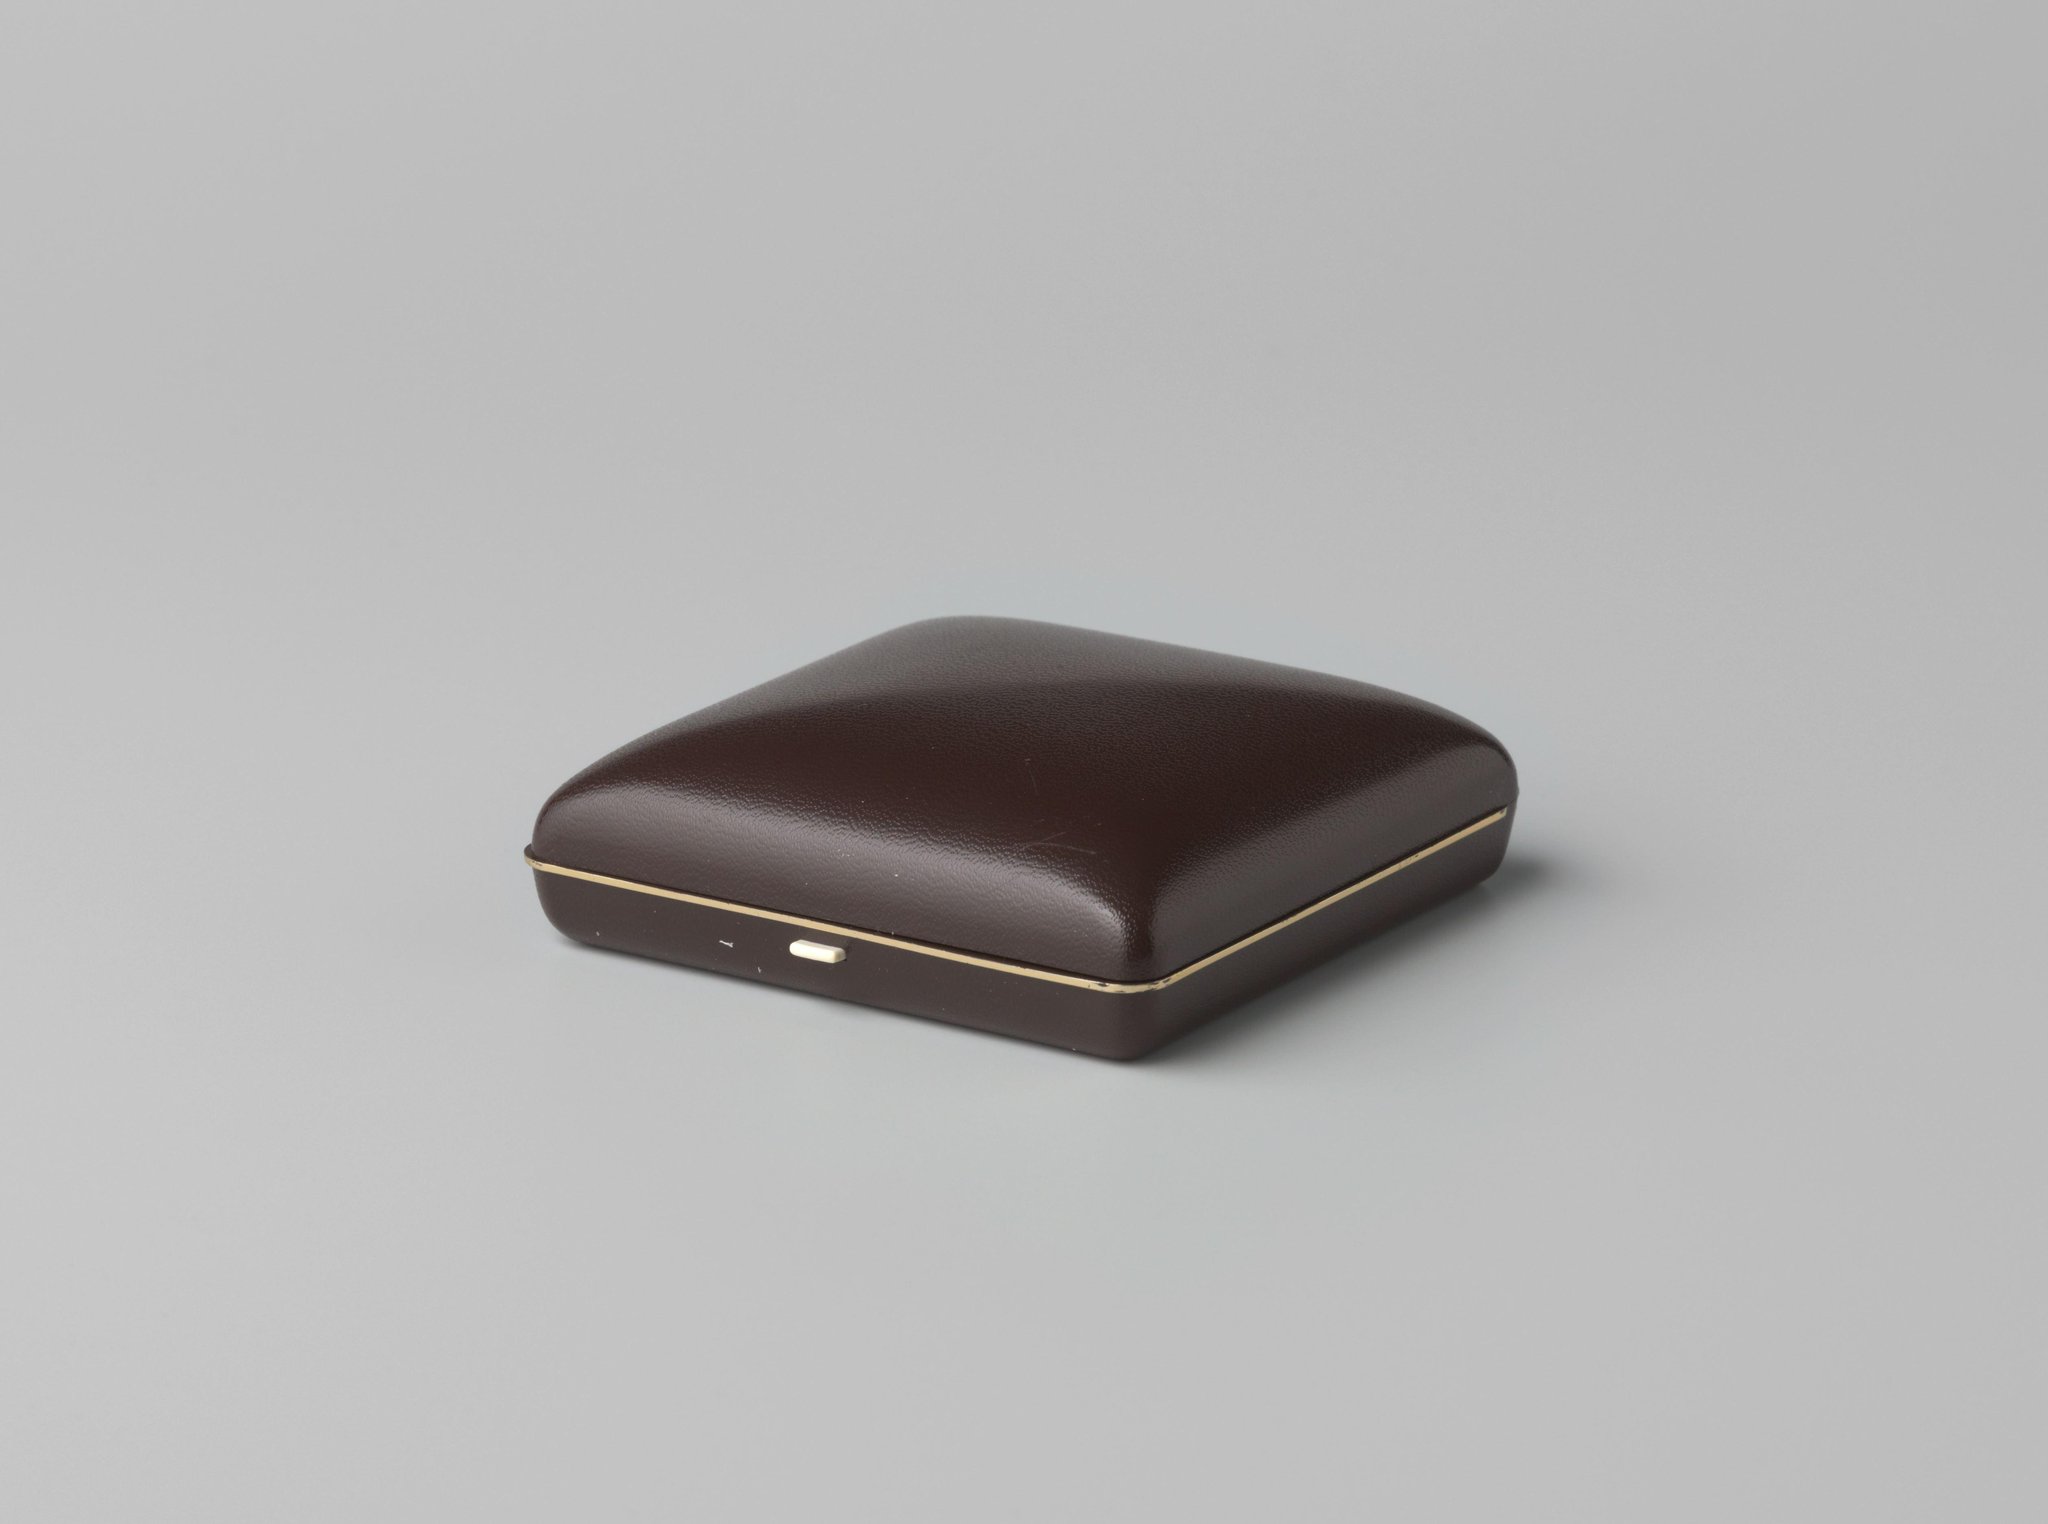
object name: juwelendoos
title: Juwelendoos en originele cornalijn van collier met zwaan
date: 1901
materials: gemstone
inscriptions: import mark: ‘dubbele adelaar (Praag, 1902-1922)’, mark: ‘C’, mark: ‘AV dooreen’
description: Juwelendoos en originele cornalijn van collier met zwaan.